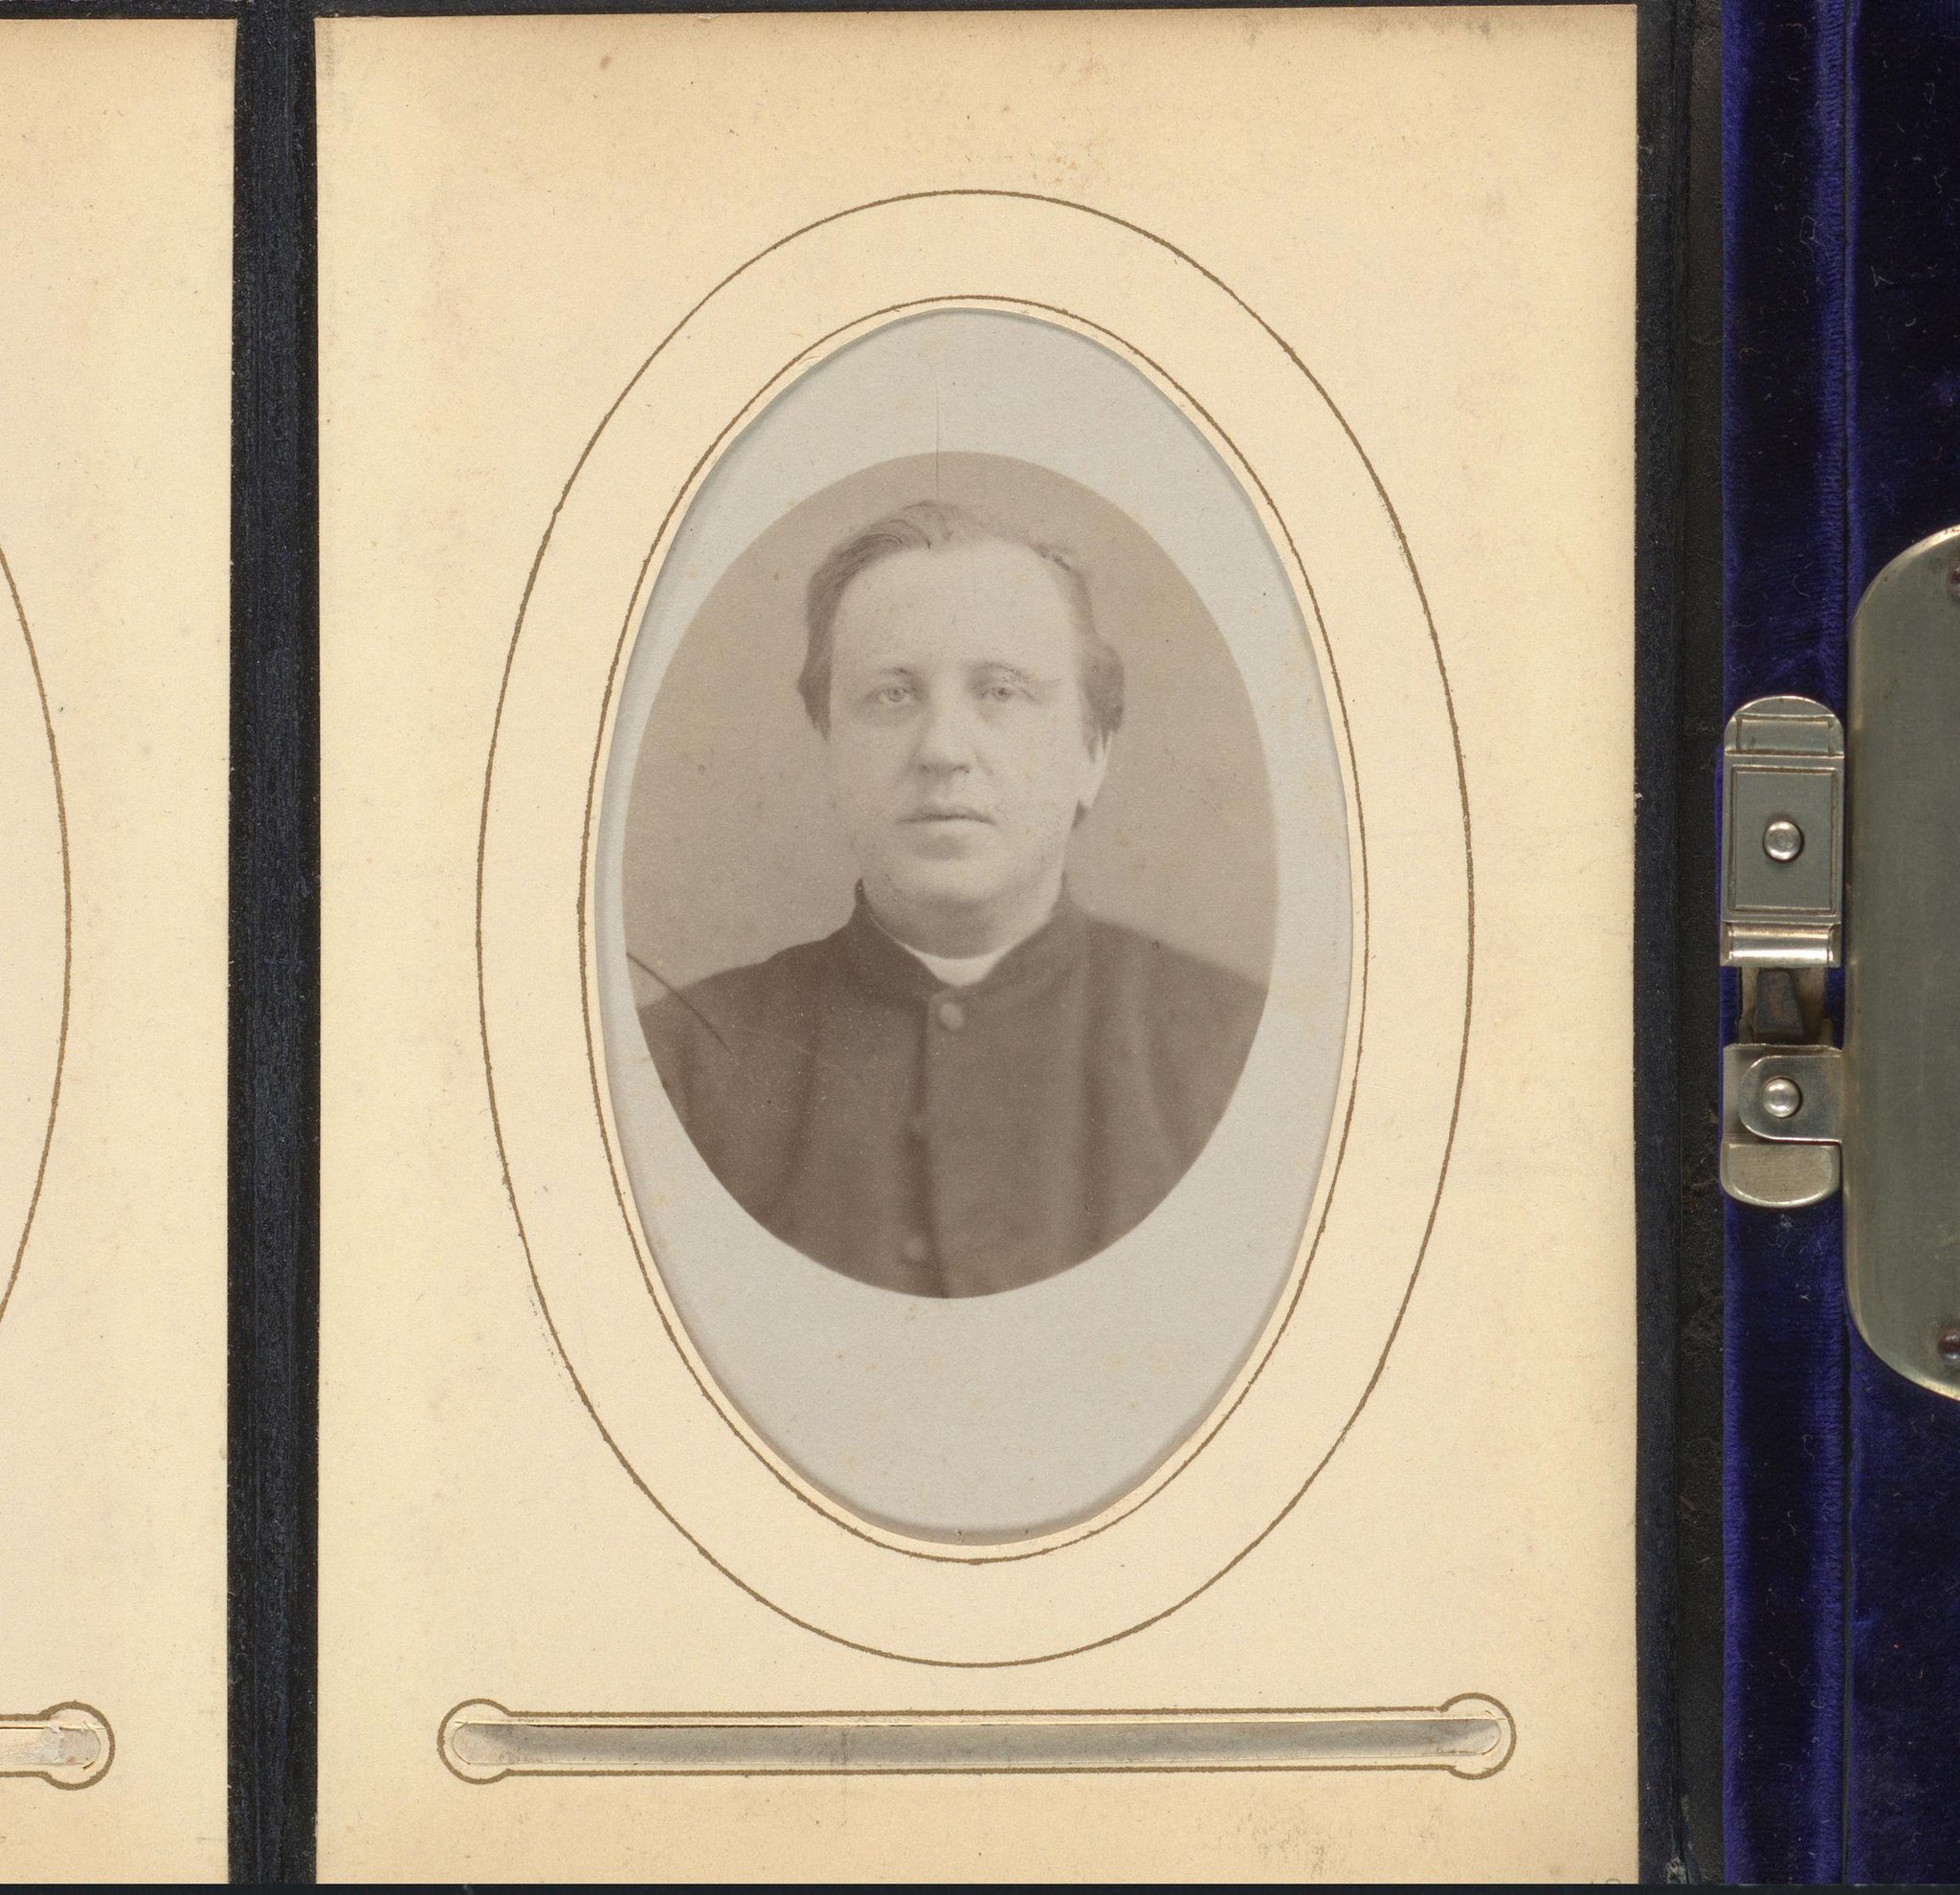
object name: carte de visite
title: Portret van een man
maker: frederik harting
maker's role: fotograaf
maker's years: 1835-1902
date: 1863-1899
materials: cardboard, photographic support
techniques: albumen print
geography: gouda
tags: historical persons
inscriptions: inscription: ‘SPECIALE INRIGTING/ VERGROOTINGEN/ IN/ KOOLDRUCK/ F. Harting/ Gouda/ OOSTHAVEN B 14./ Portretten in kleuren met echt Englische Aquarel verven./ Onveranderlÿk.’